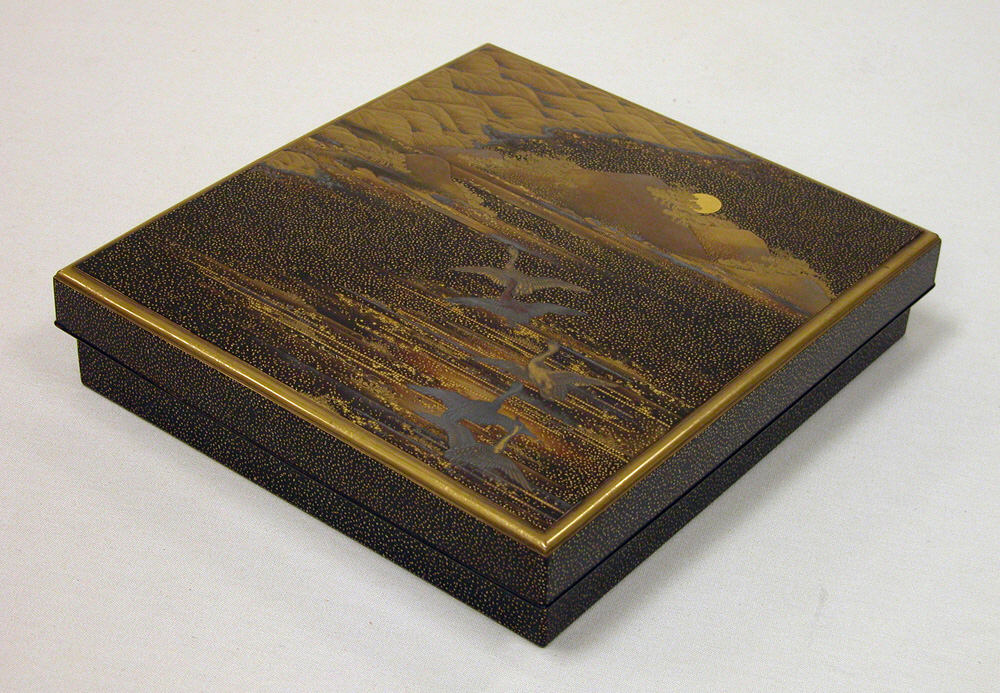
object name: writing box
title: Writing Box with Flying Geese in the Autumn Night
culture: japanese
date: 1701-1800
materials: gold, lacquer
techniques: maki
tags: birds,moon